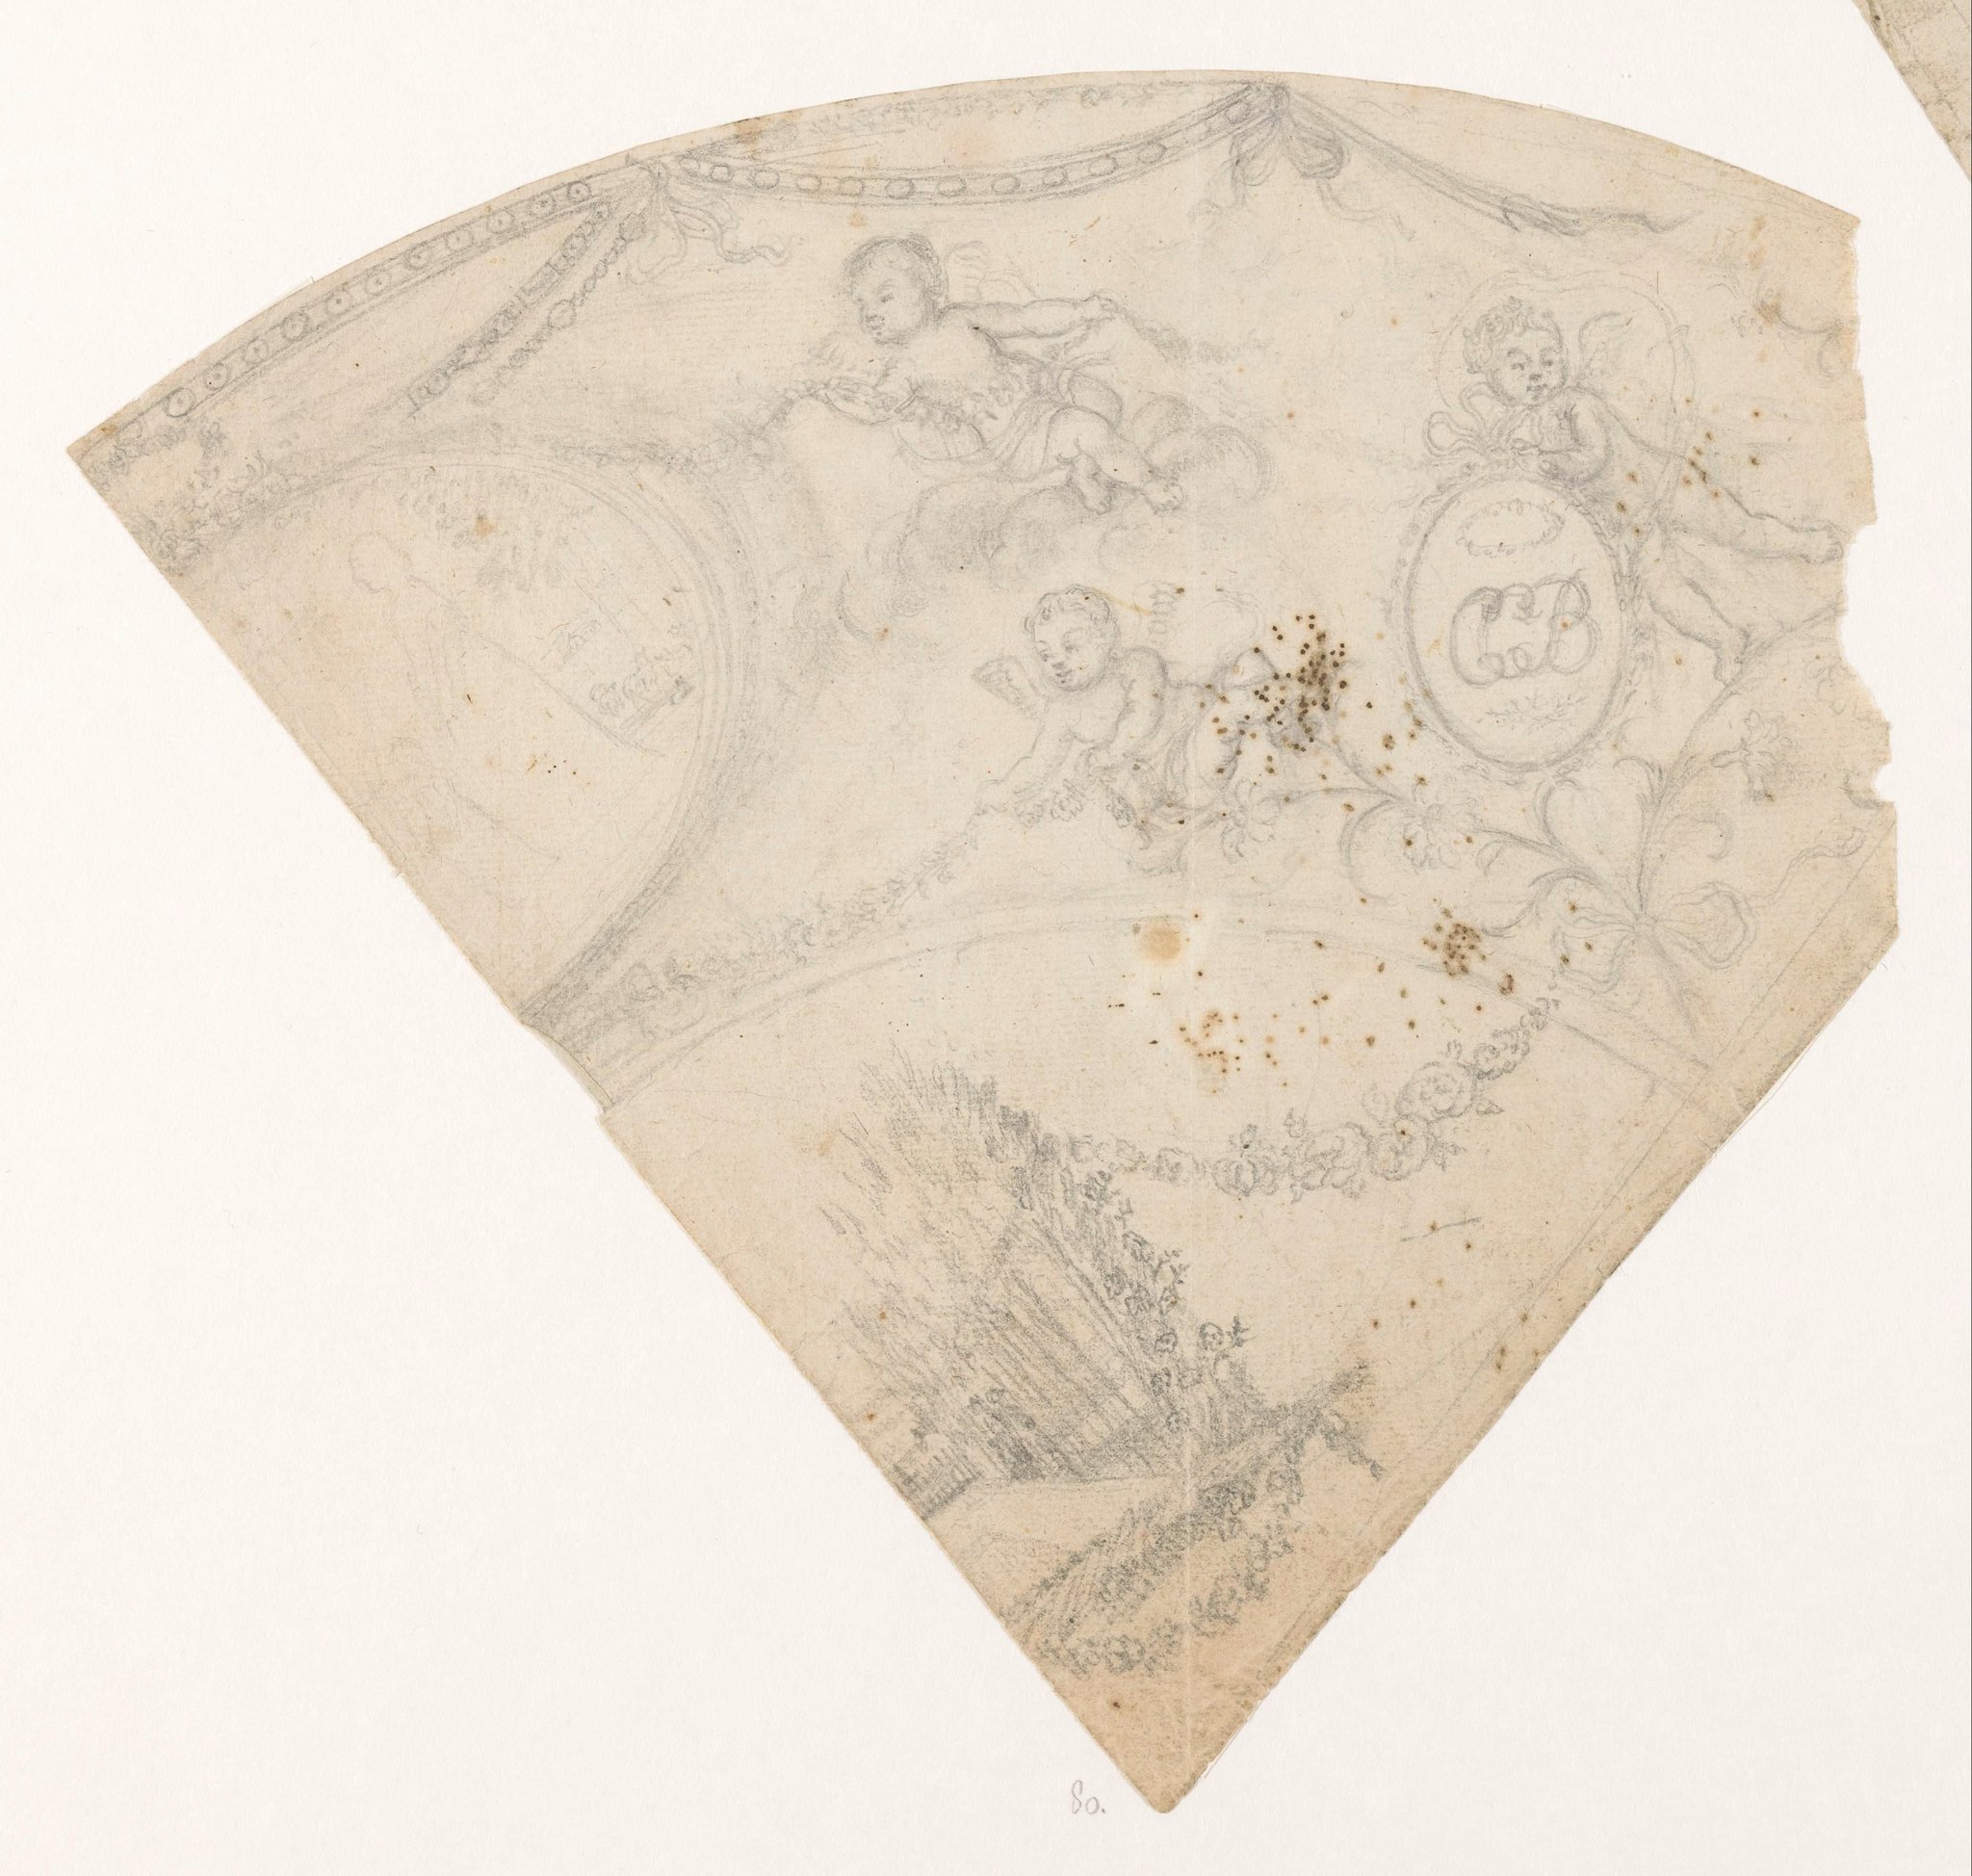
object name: drawing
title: Decoratie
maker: jan brandes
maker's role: draughtsman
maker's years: 1743-1808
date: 1770-1808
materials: paper, pencil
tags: cupids: 'amores', 'amoretti', 'putti'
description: Deel van de decoratie voor een plafond: engeltjes, een monogram en een oprijlaan of perk. Het papier is gesneden in de vorm van een waaier.